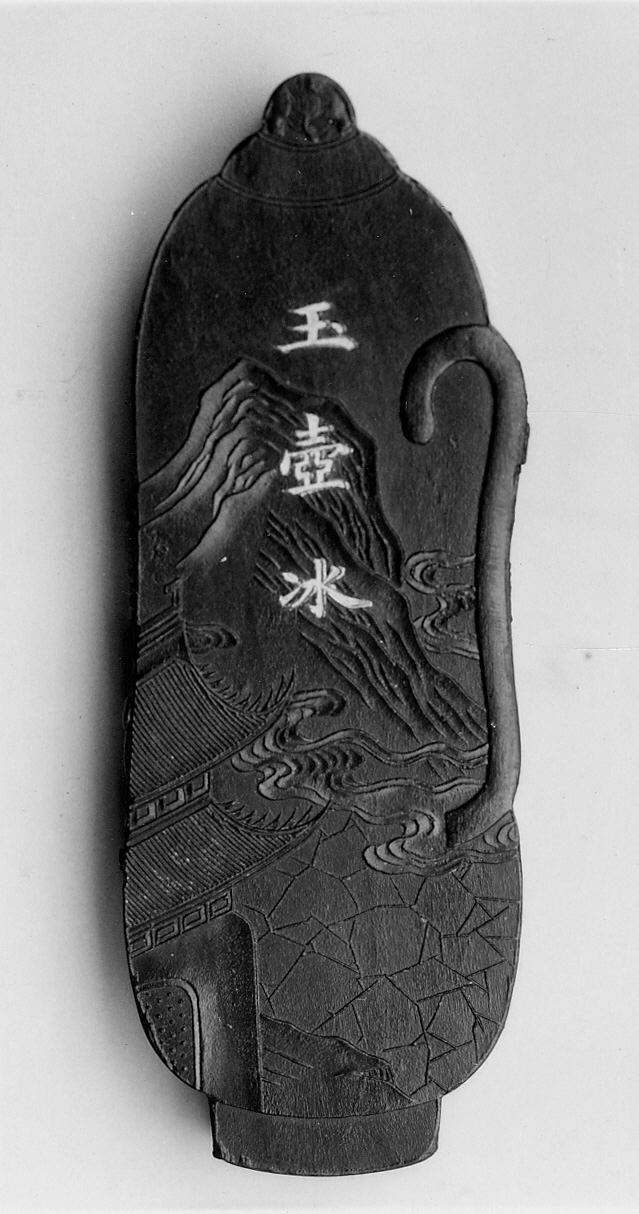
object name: ink tablet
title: Jade Pots of Ice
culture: chinese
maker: jian guzhai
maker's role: artist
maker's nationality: chinese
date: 1867-1933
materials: gilt, wood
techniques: bookbinding